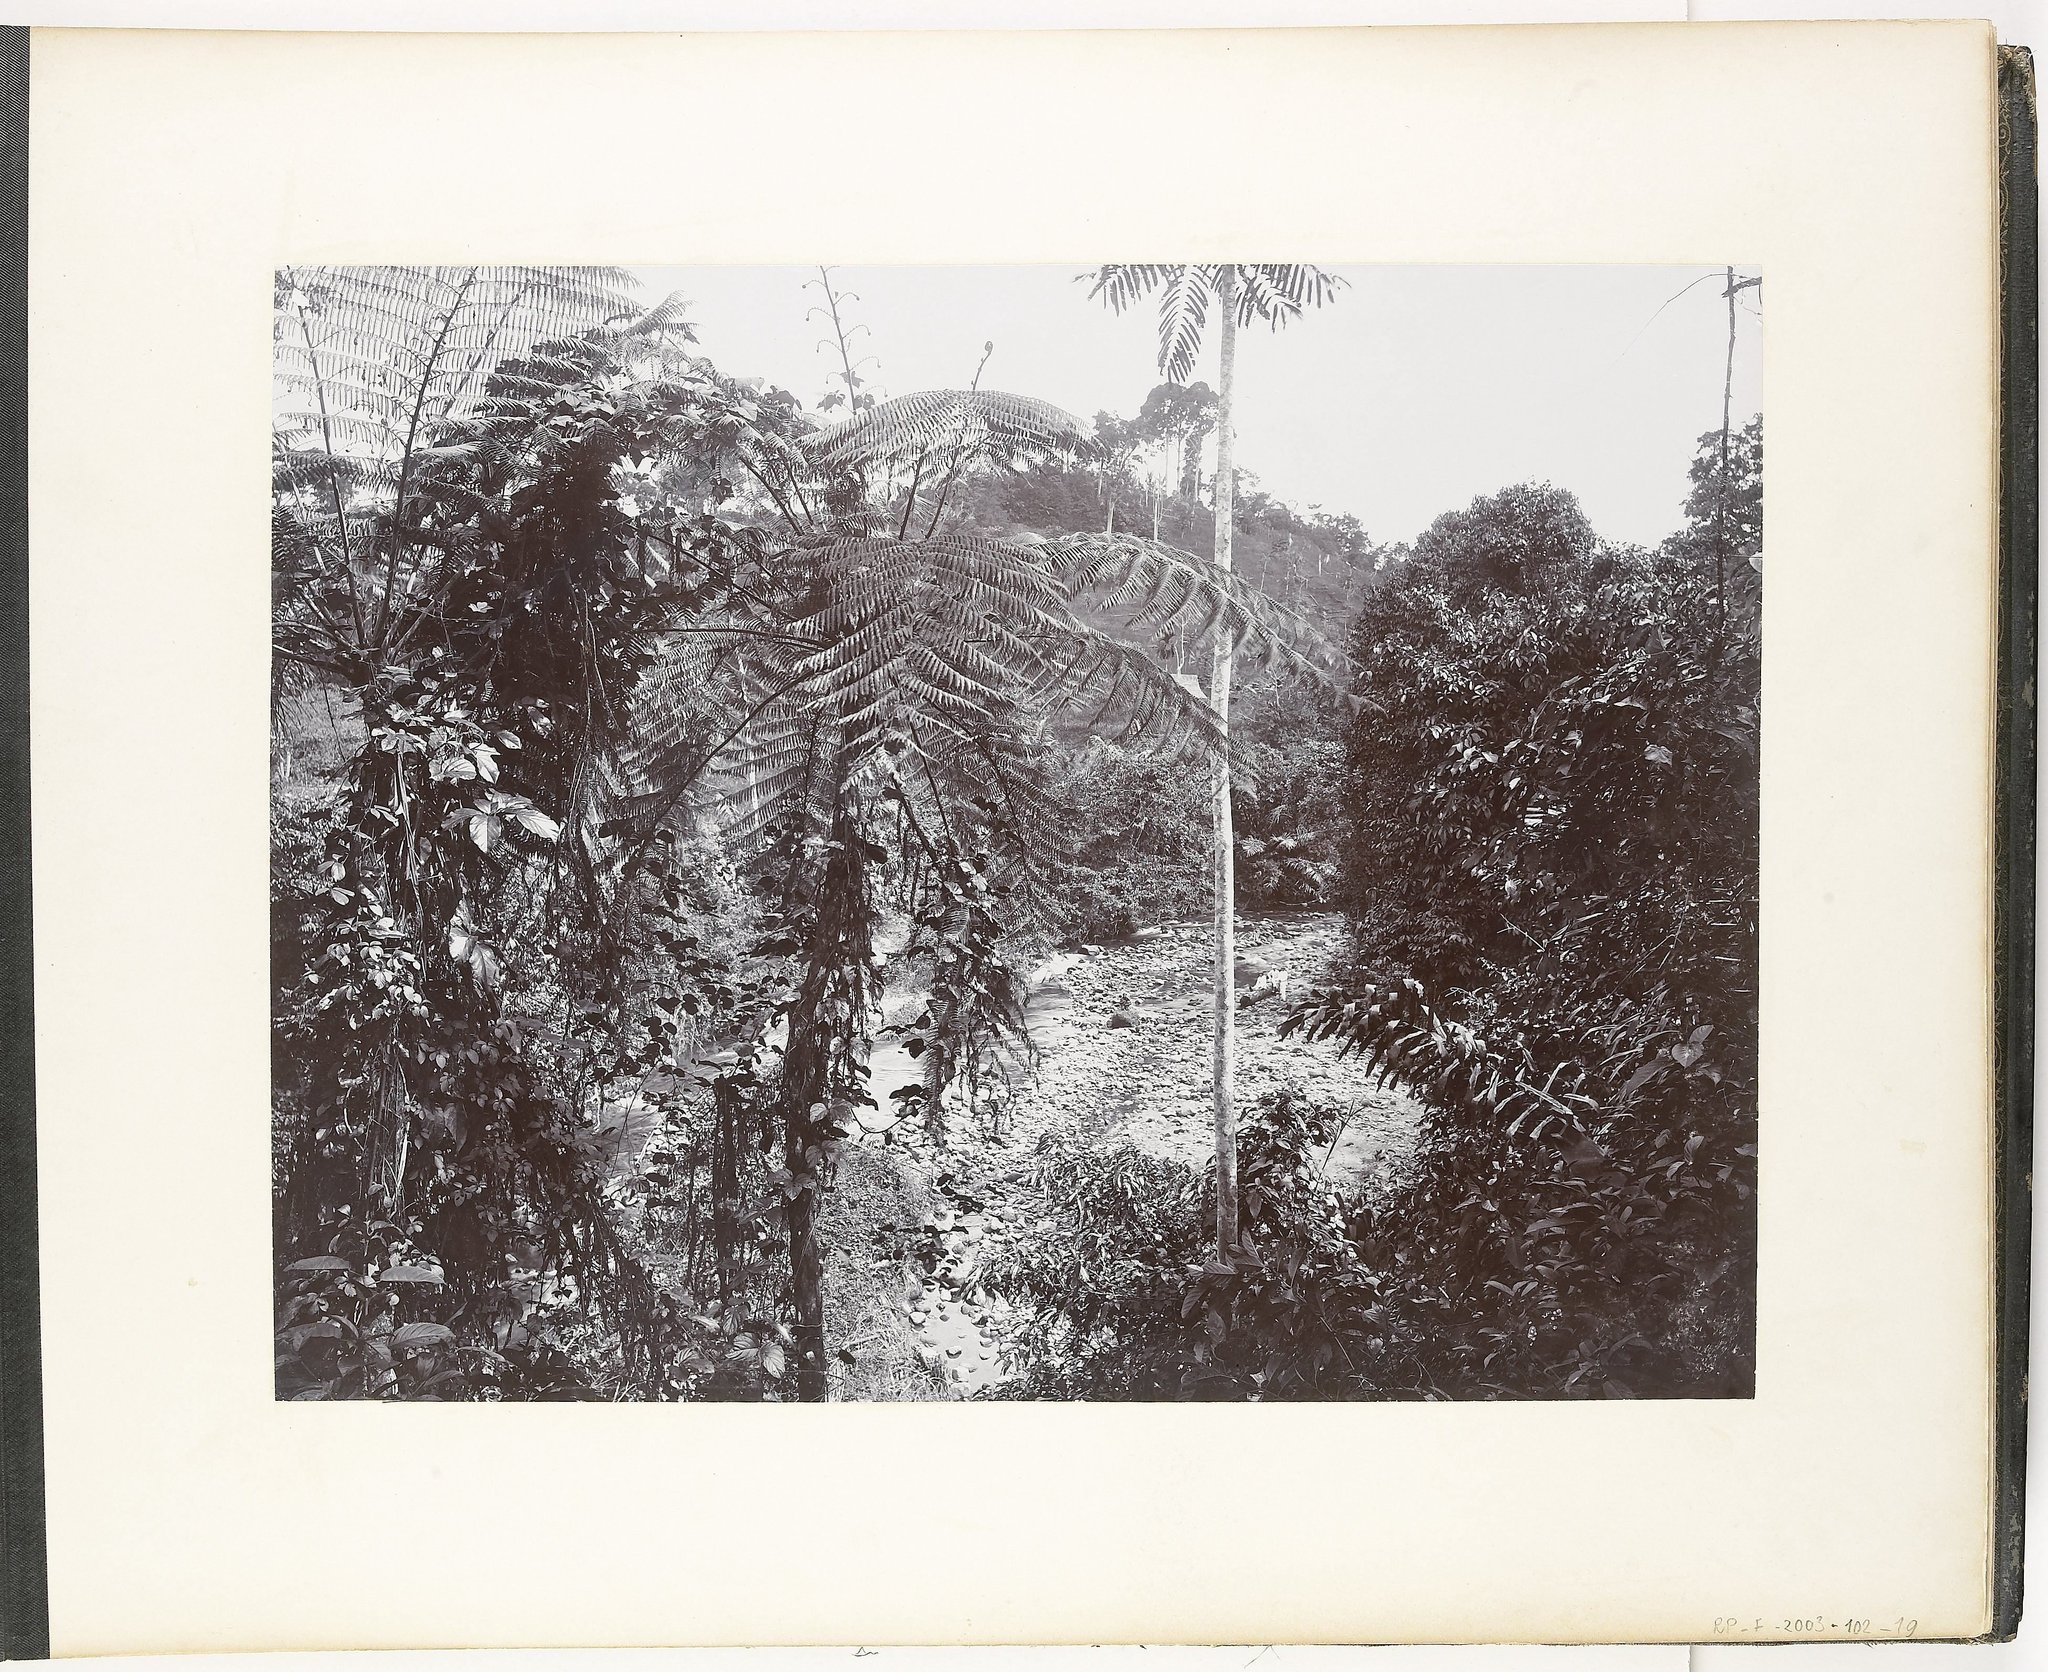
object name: photograph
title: Gezicht op het woud, Rimhoen Estate, Sumatra (Waldparthie Rimhoen Estate)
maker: carl j. kleingrothe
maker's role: fotograaf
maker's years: 1864-1925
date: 1885-1900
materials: photographic support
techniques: collodion silver print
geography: medan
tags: sumatra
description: Gezicht door bomen in het woud op een rivierbedding, bij de Rimhoen (?) Plantage. Onderdeel van het Sumatra fotoalbum van Paul en Lucie Sandel uit 1900.